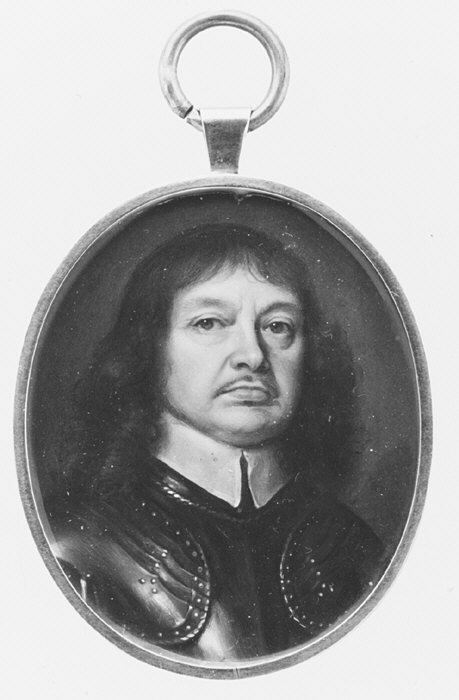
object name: painting, miniature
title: Portrait of a Man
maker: monogrammist fs (franciszek smiadecki?)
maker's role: artist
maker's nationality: british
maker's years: 1650-1665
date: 1650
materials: oil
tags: men,portraits